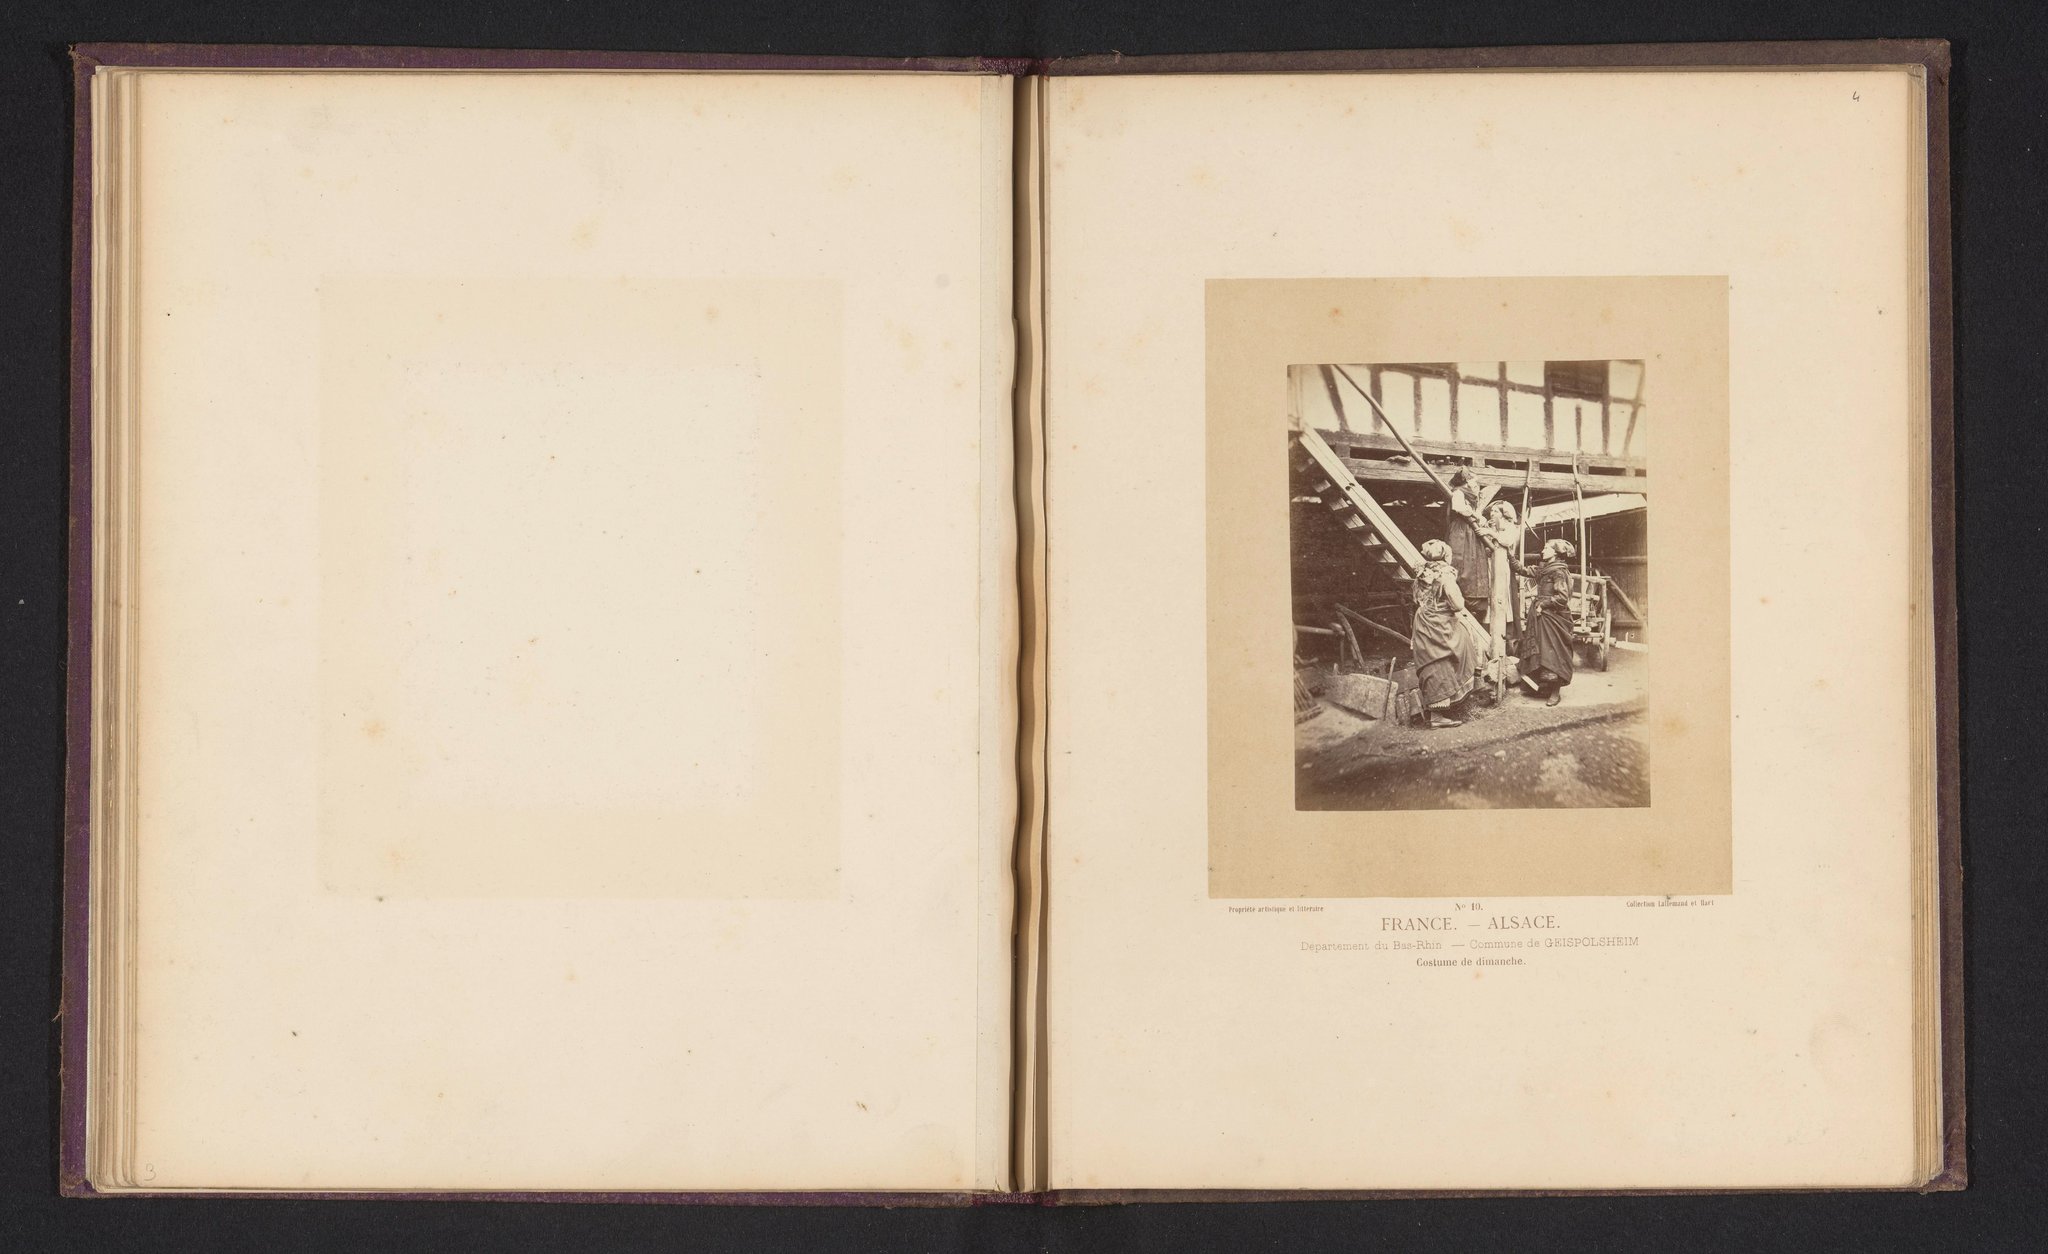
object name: photograph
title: Vier vrouwen in zondagse kleding te Geispolsheim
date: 1855-1865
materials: photographic support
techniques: albumen print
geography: geispolsheim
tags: stairwell, adolescent, young woman, maiden, clothes for official occasions, folk costume, regional costume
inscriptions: number: ‘4’, inscription: ‘France. Alsace. Departement du Bas-Rhin.- Commune de Geispolsheim’, number: ‘No. 10.’